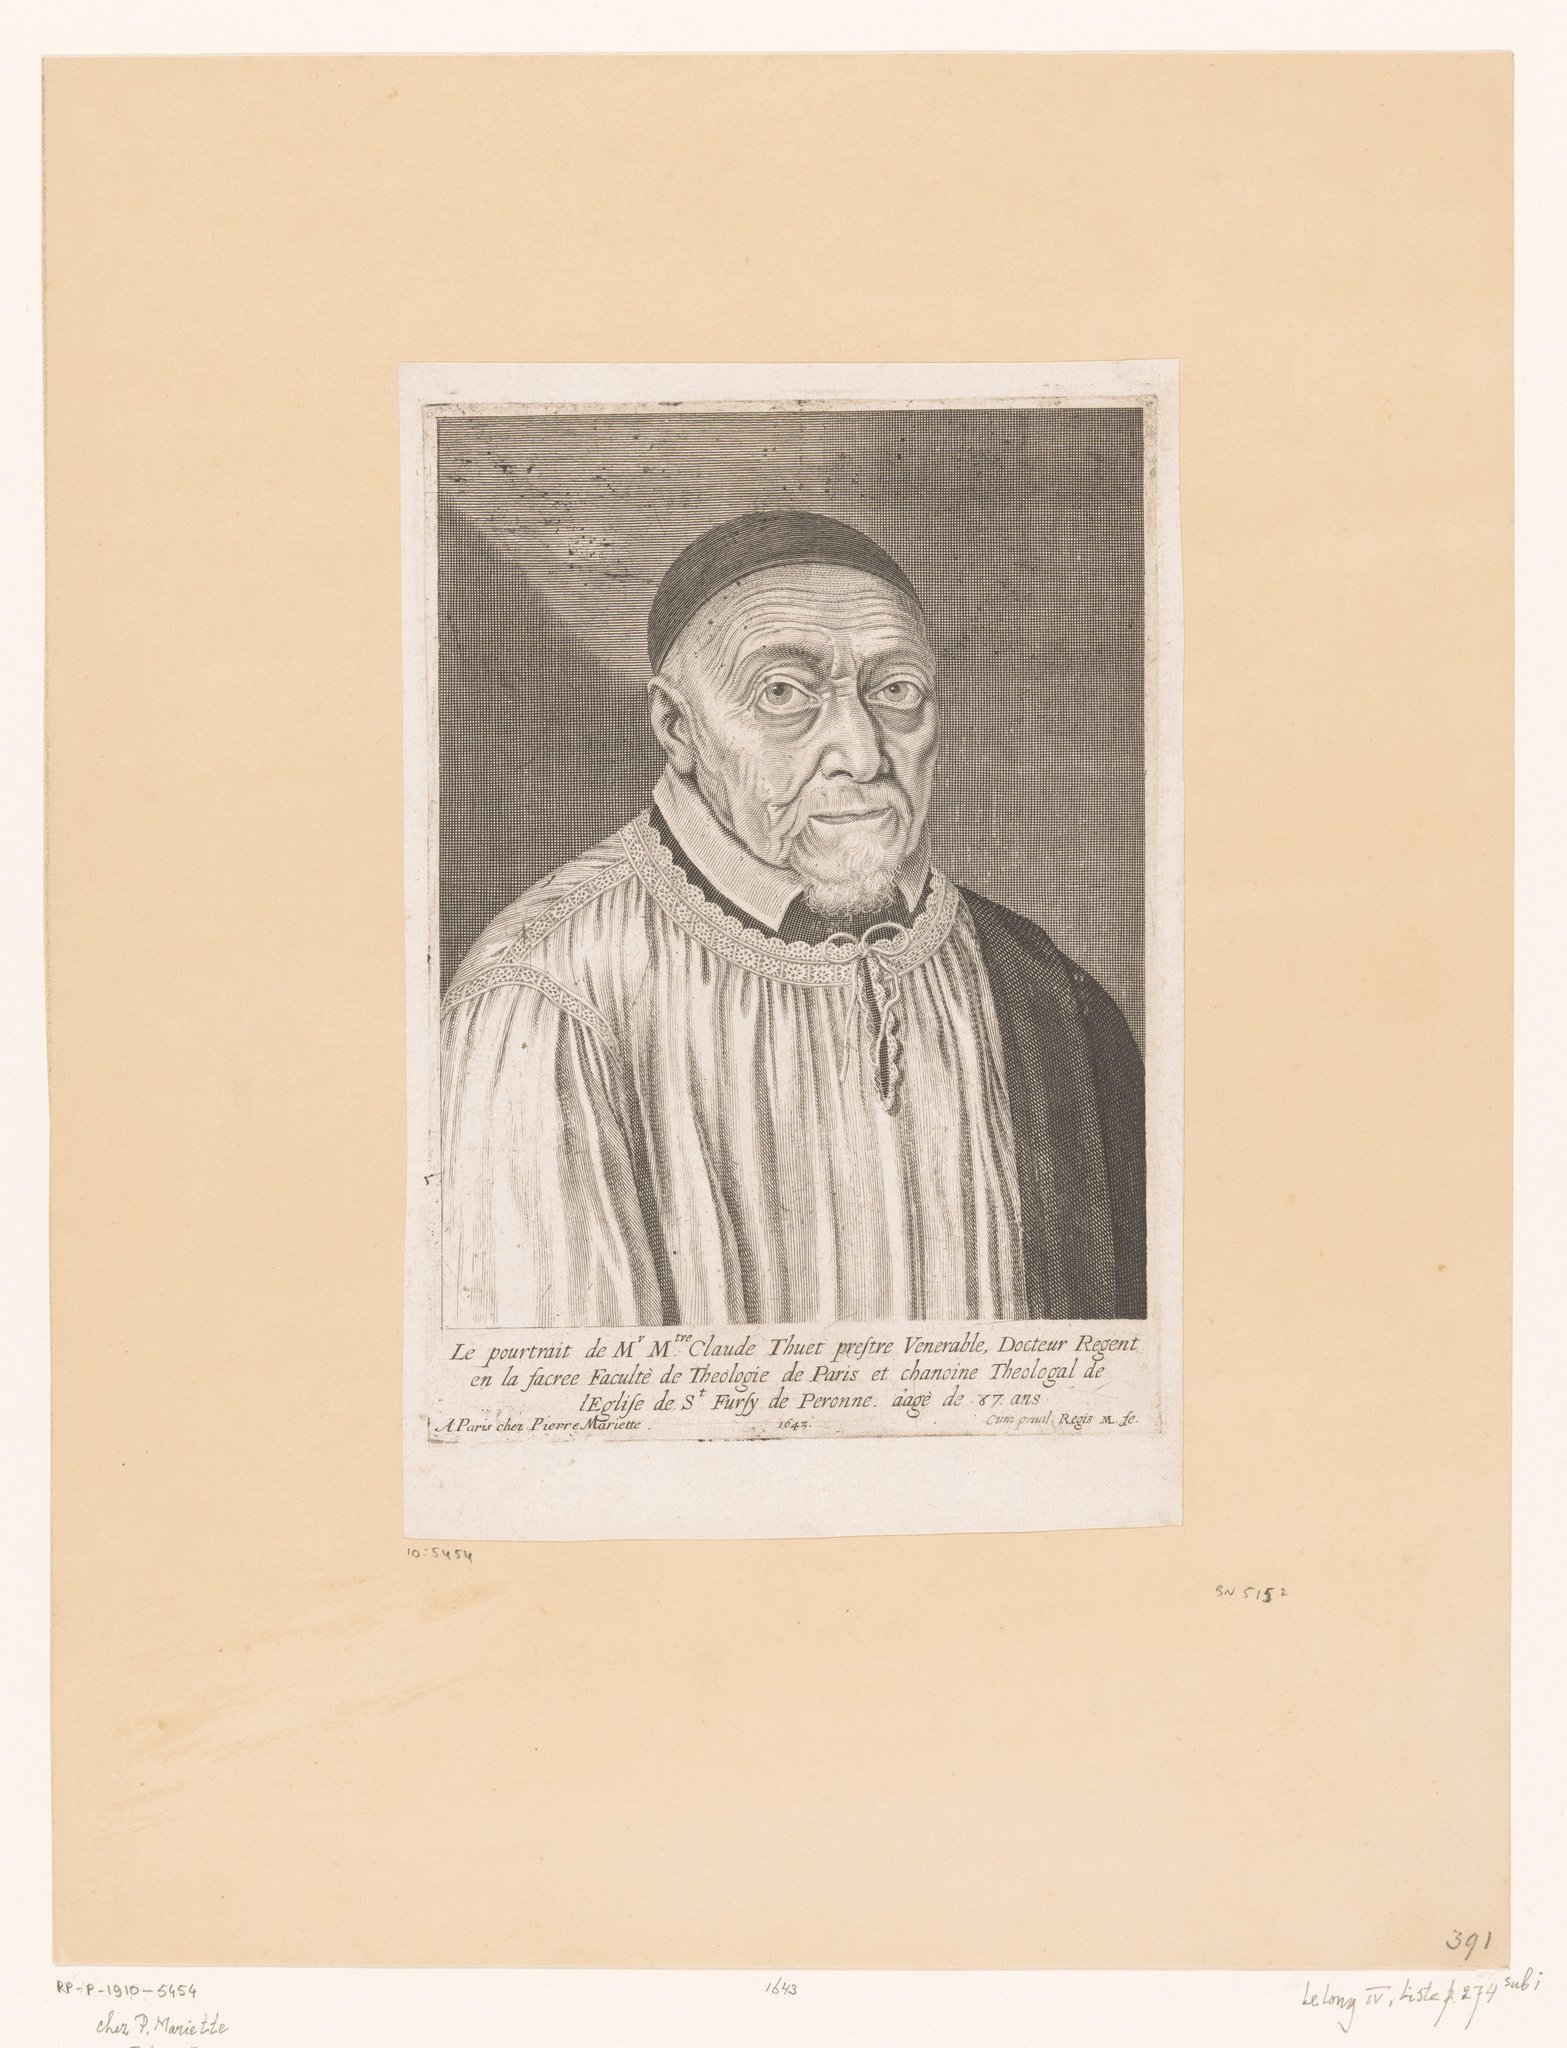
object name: print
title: Portret van Claude Thuet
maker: michel lasne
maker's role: print maker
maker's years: 1590-1667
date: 1643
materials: paper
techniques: engraving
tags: historical persons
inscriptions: collector's mark: Lugt 2228